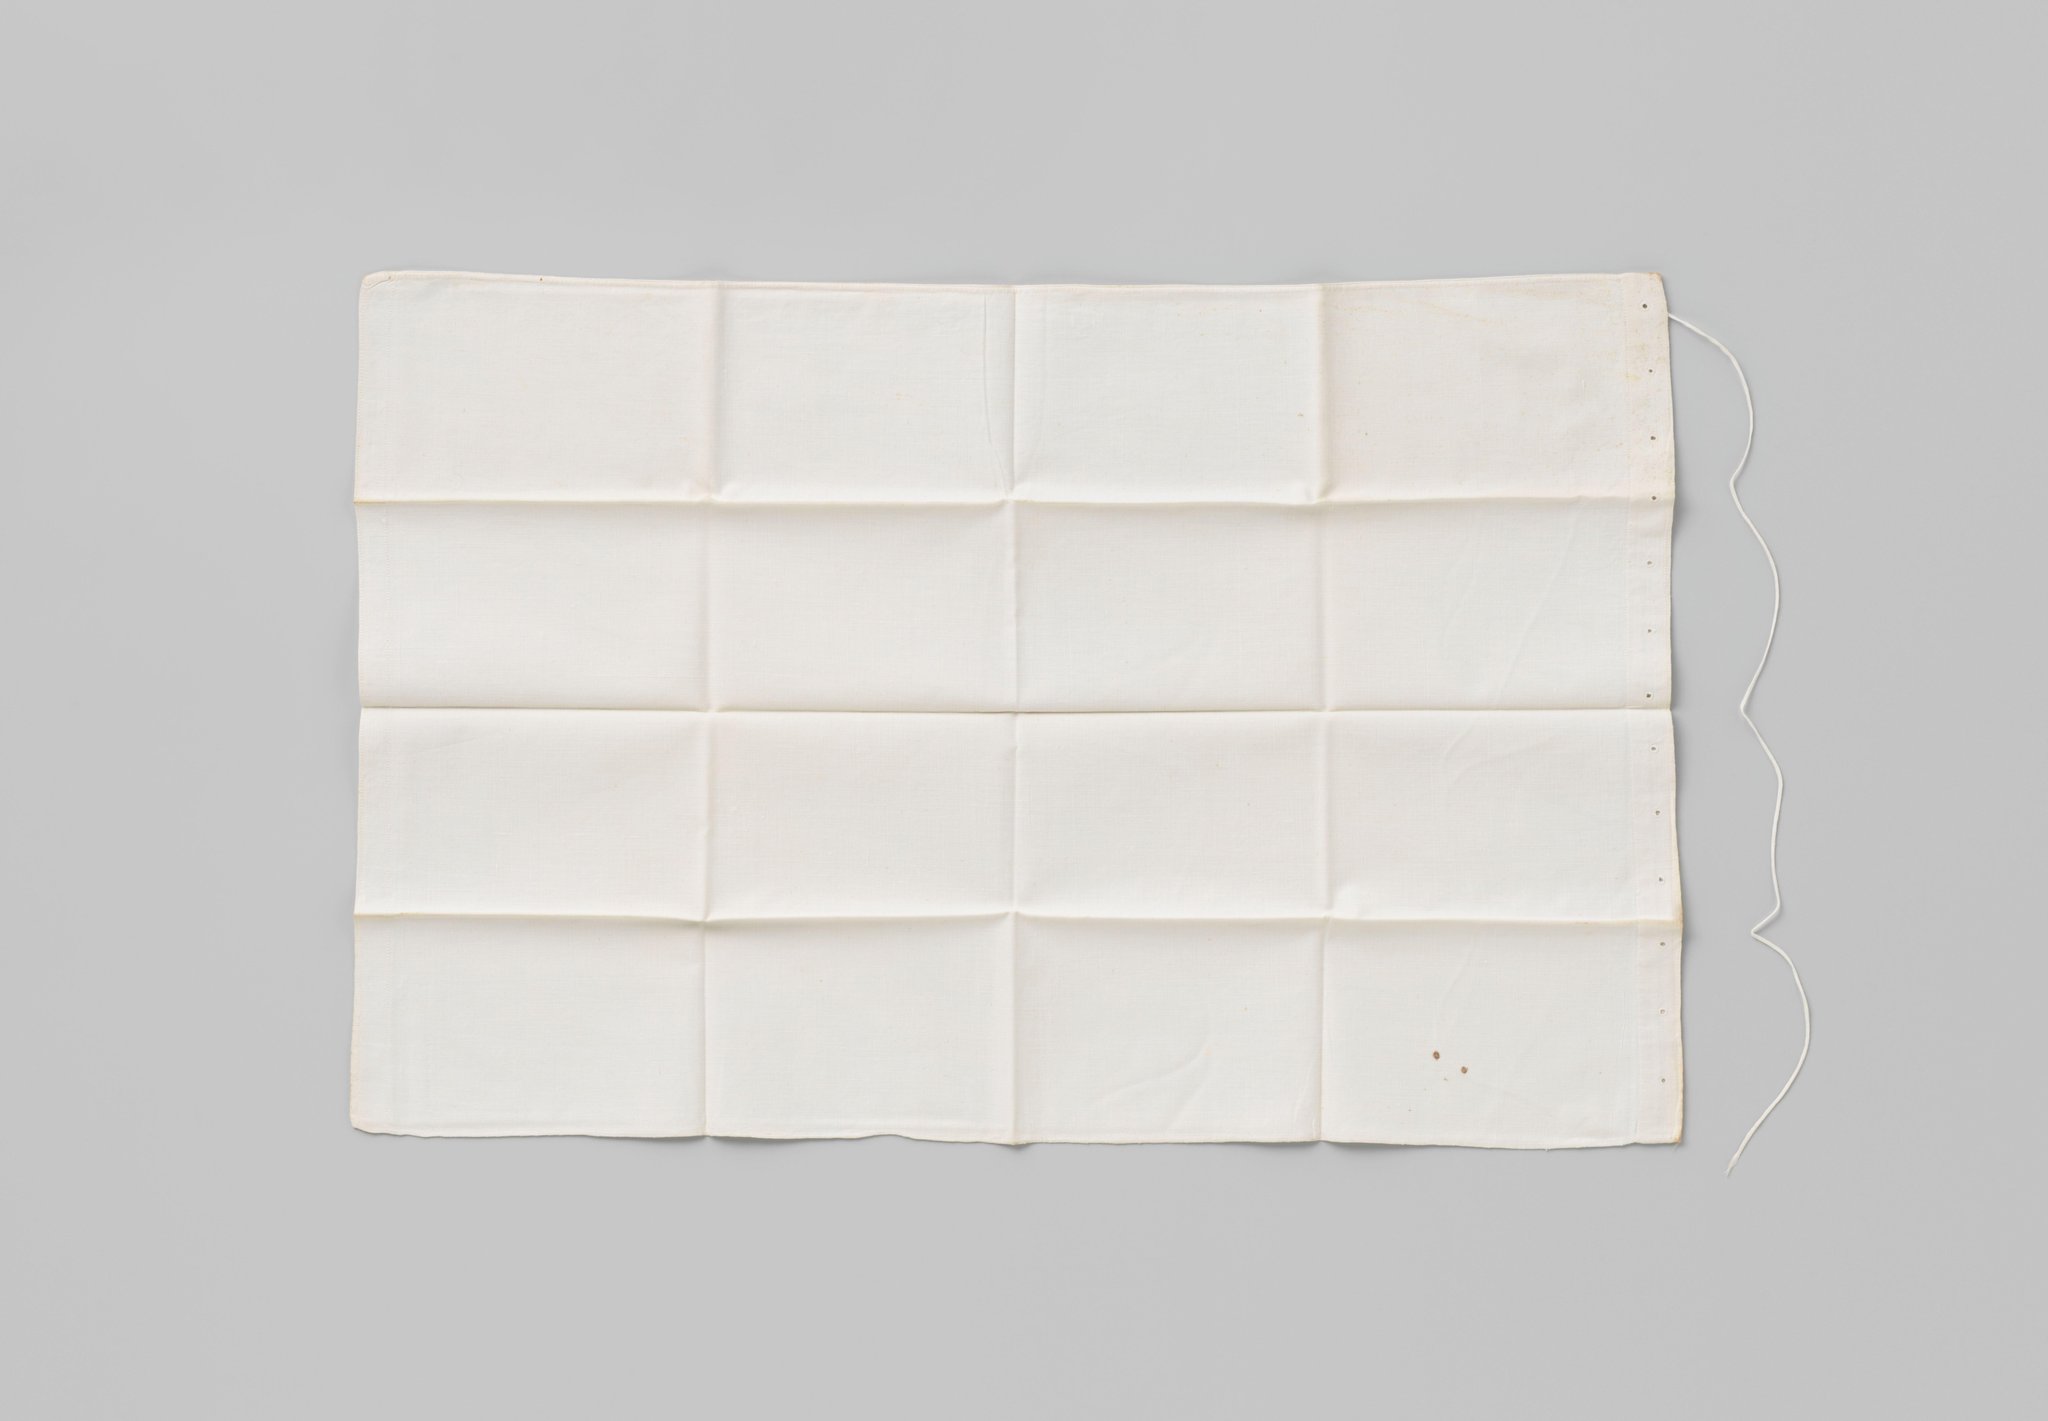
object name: lendensloop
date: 1800-1866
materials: cotton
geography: northern netherlands